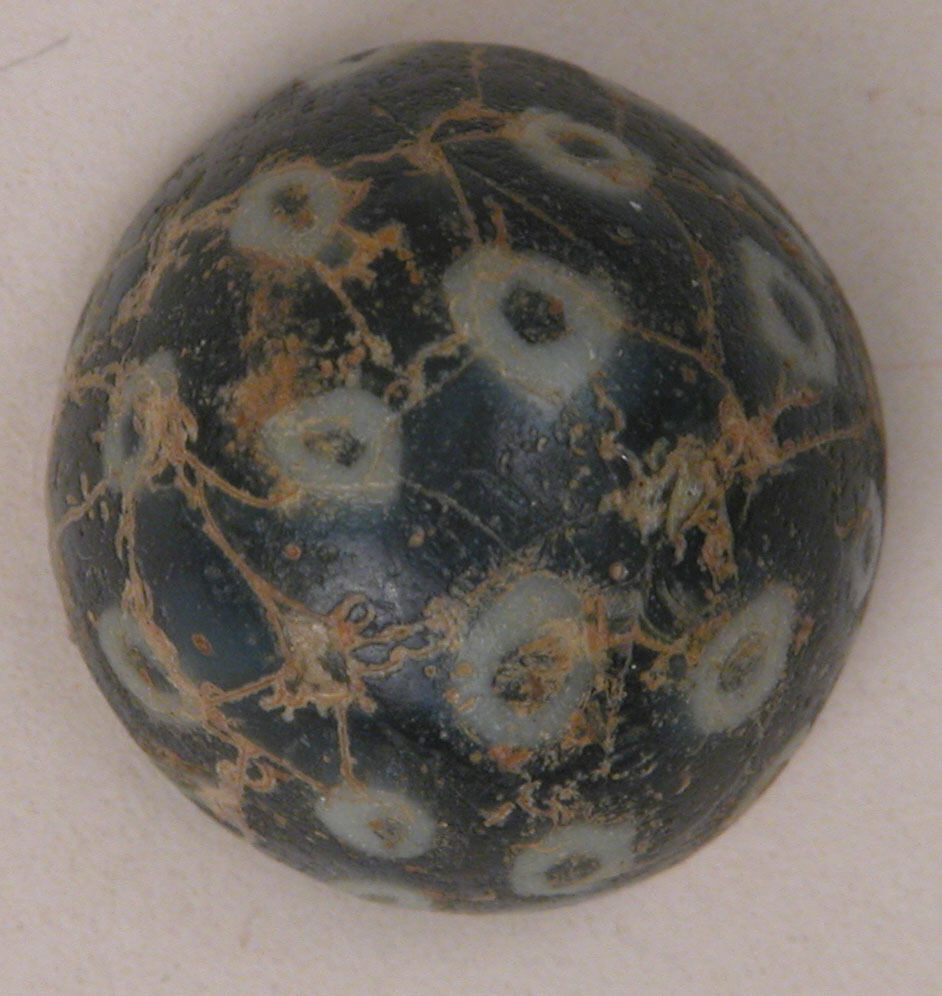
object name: gaming piece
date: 701-1200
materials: glass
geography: islamic lands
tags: games